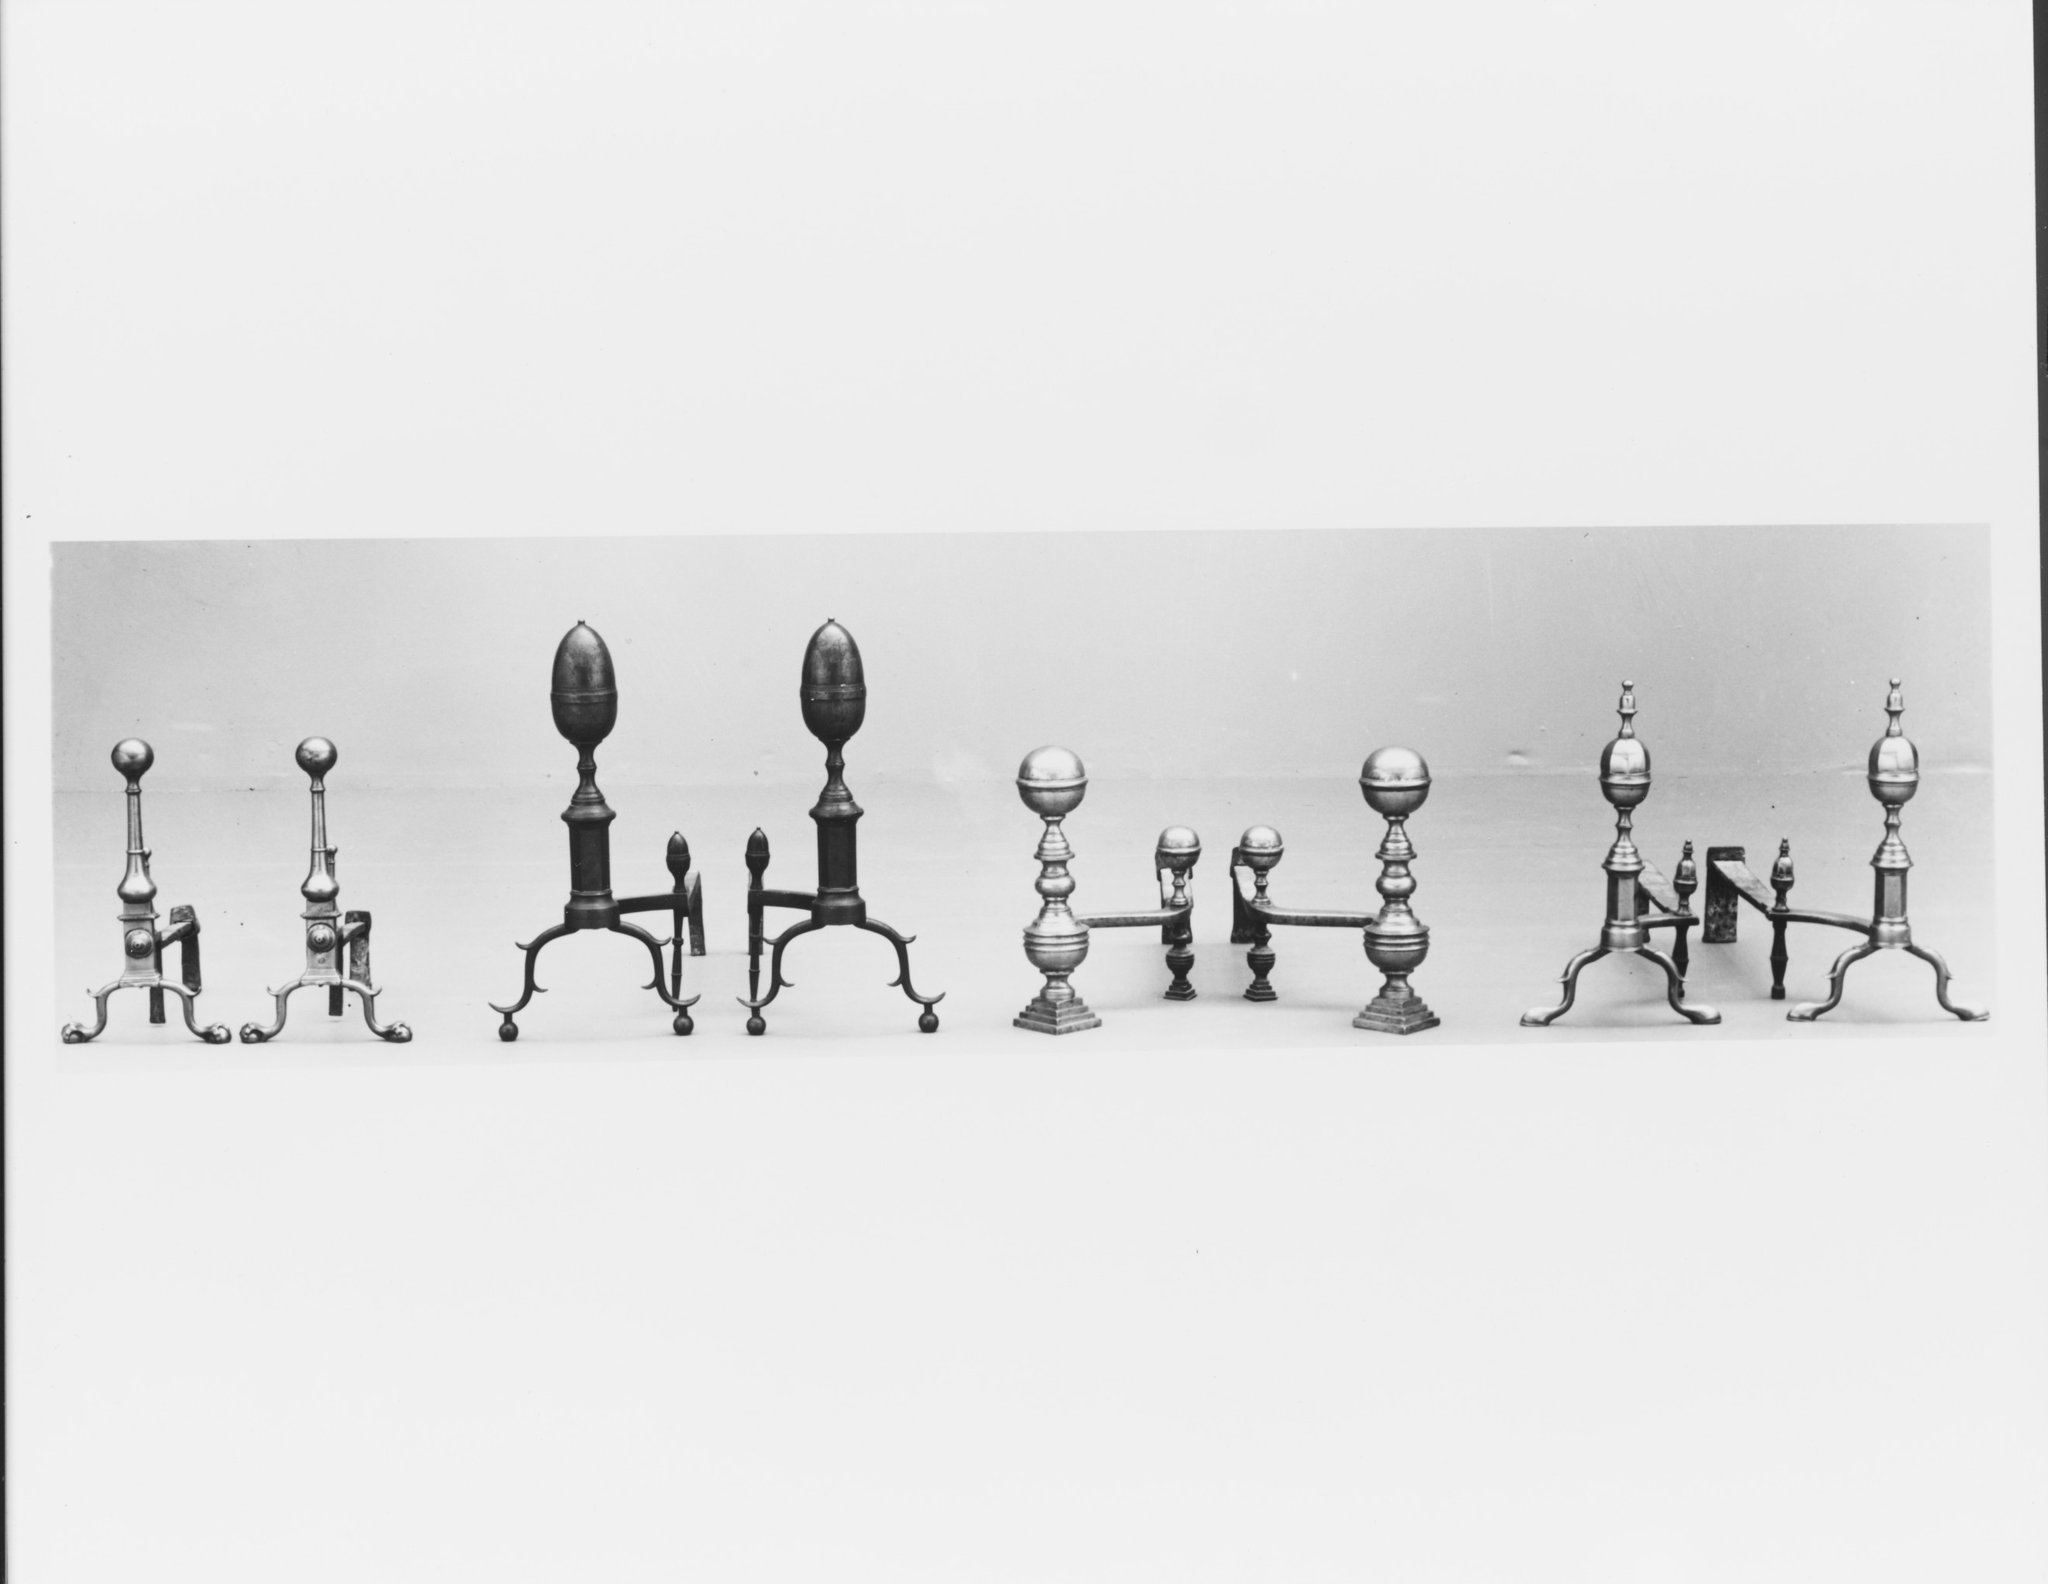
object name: andiron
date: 1700-1800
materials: metal